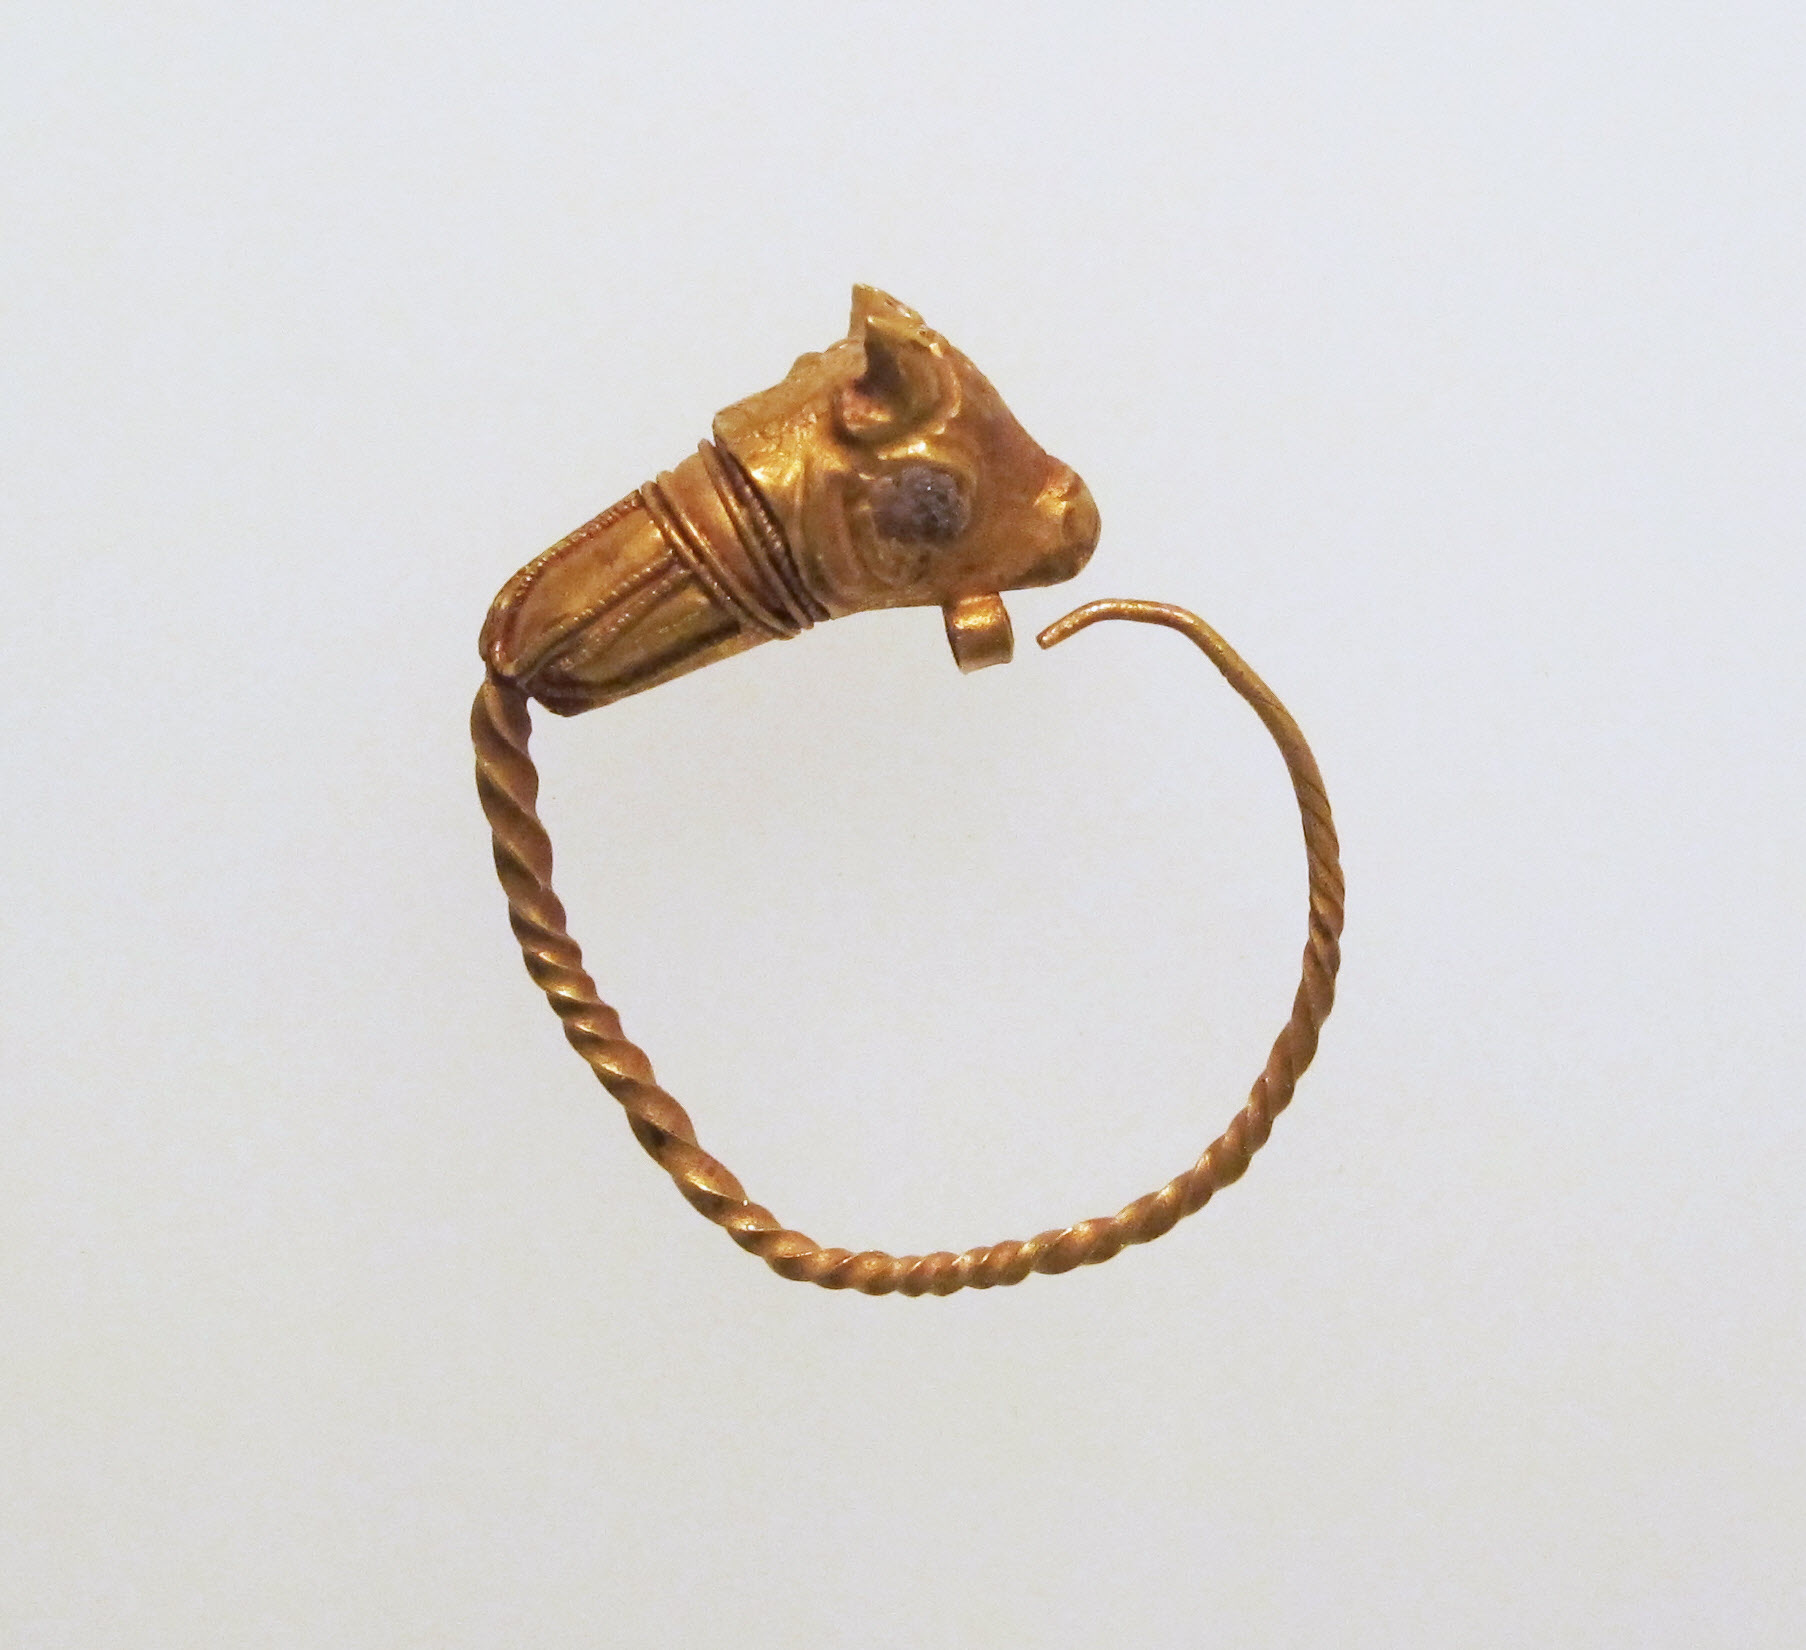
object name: earring with head of bull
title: Gold earring with head of a bull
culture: greek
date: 400-201 BCE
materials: gold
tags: bulls